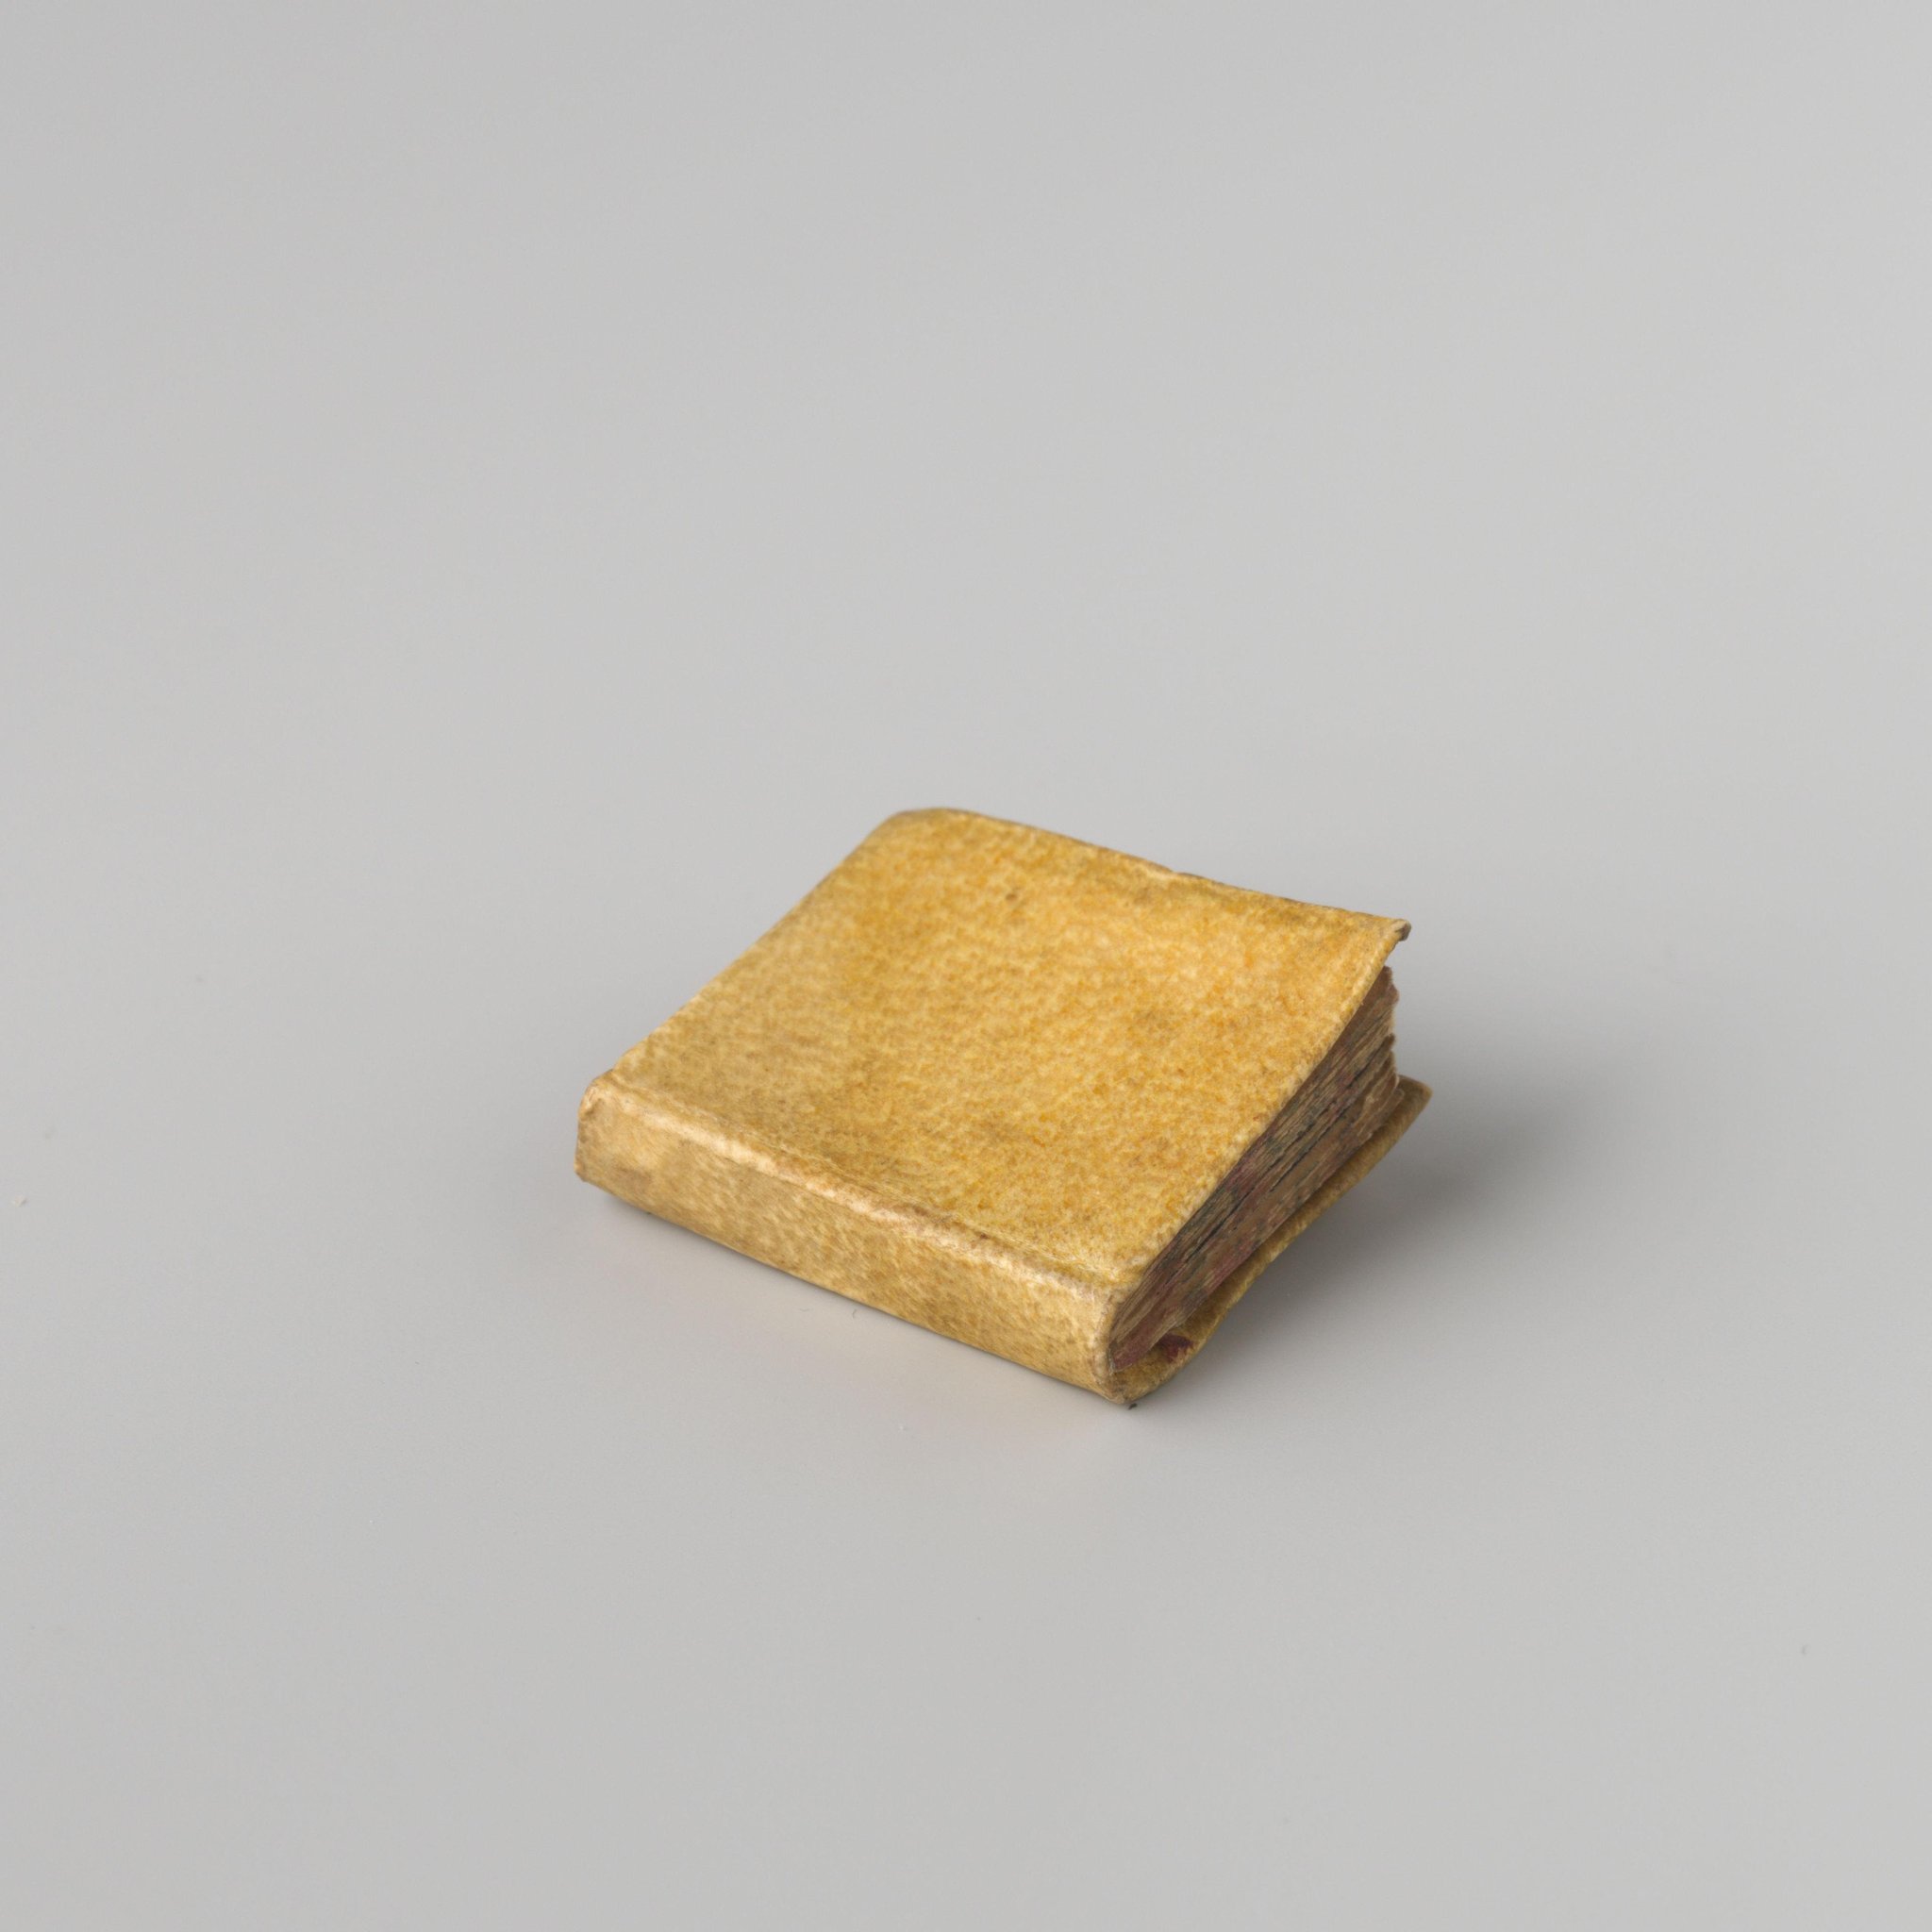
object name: book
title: Boek met tuingezichten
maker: Anonymous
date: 1690-1710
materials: paper, parchment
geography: amsterdam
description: Boek met tuingezichten. Ingebonden in geel gekleurd perkament.